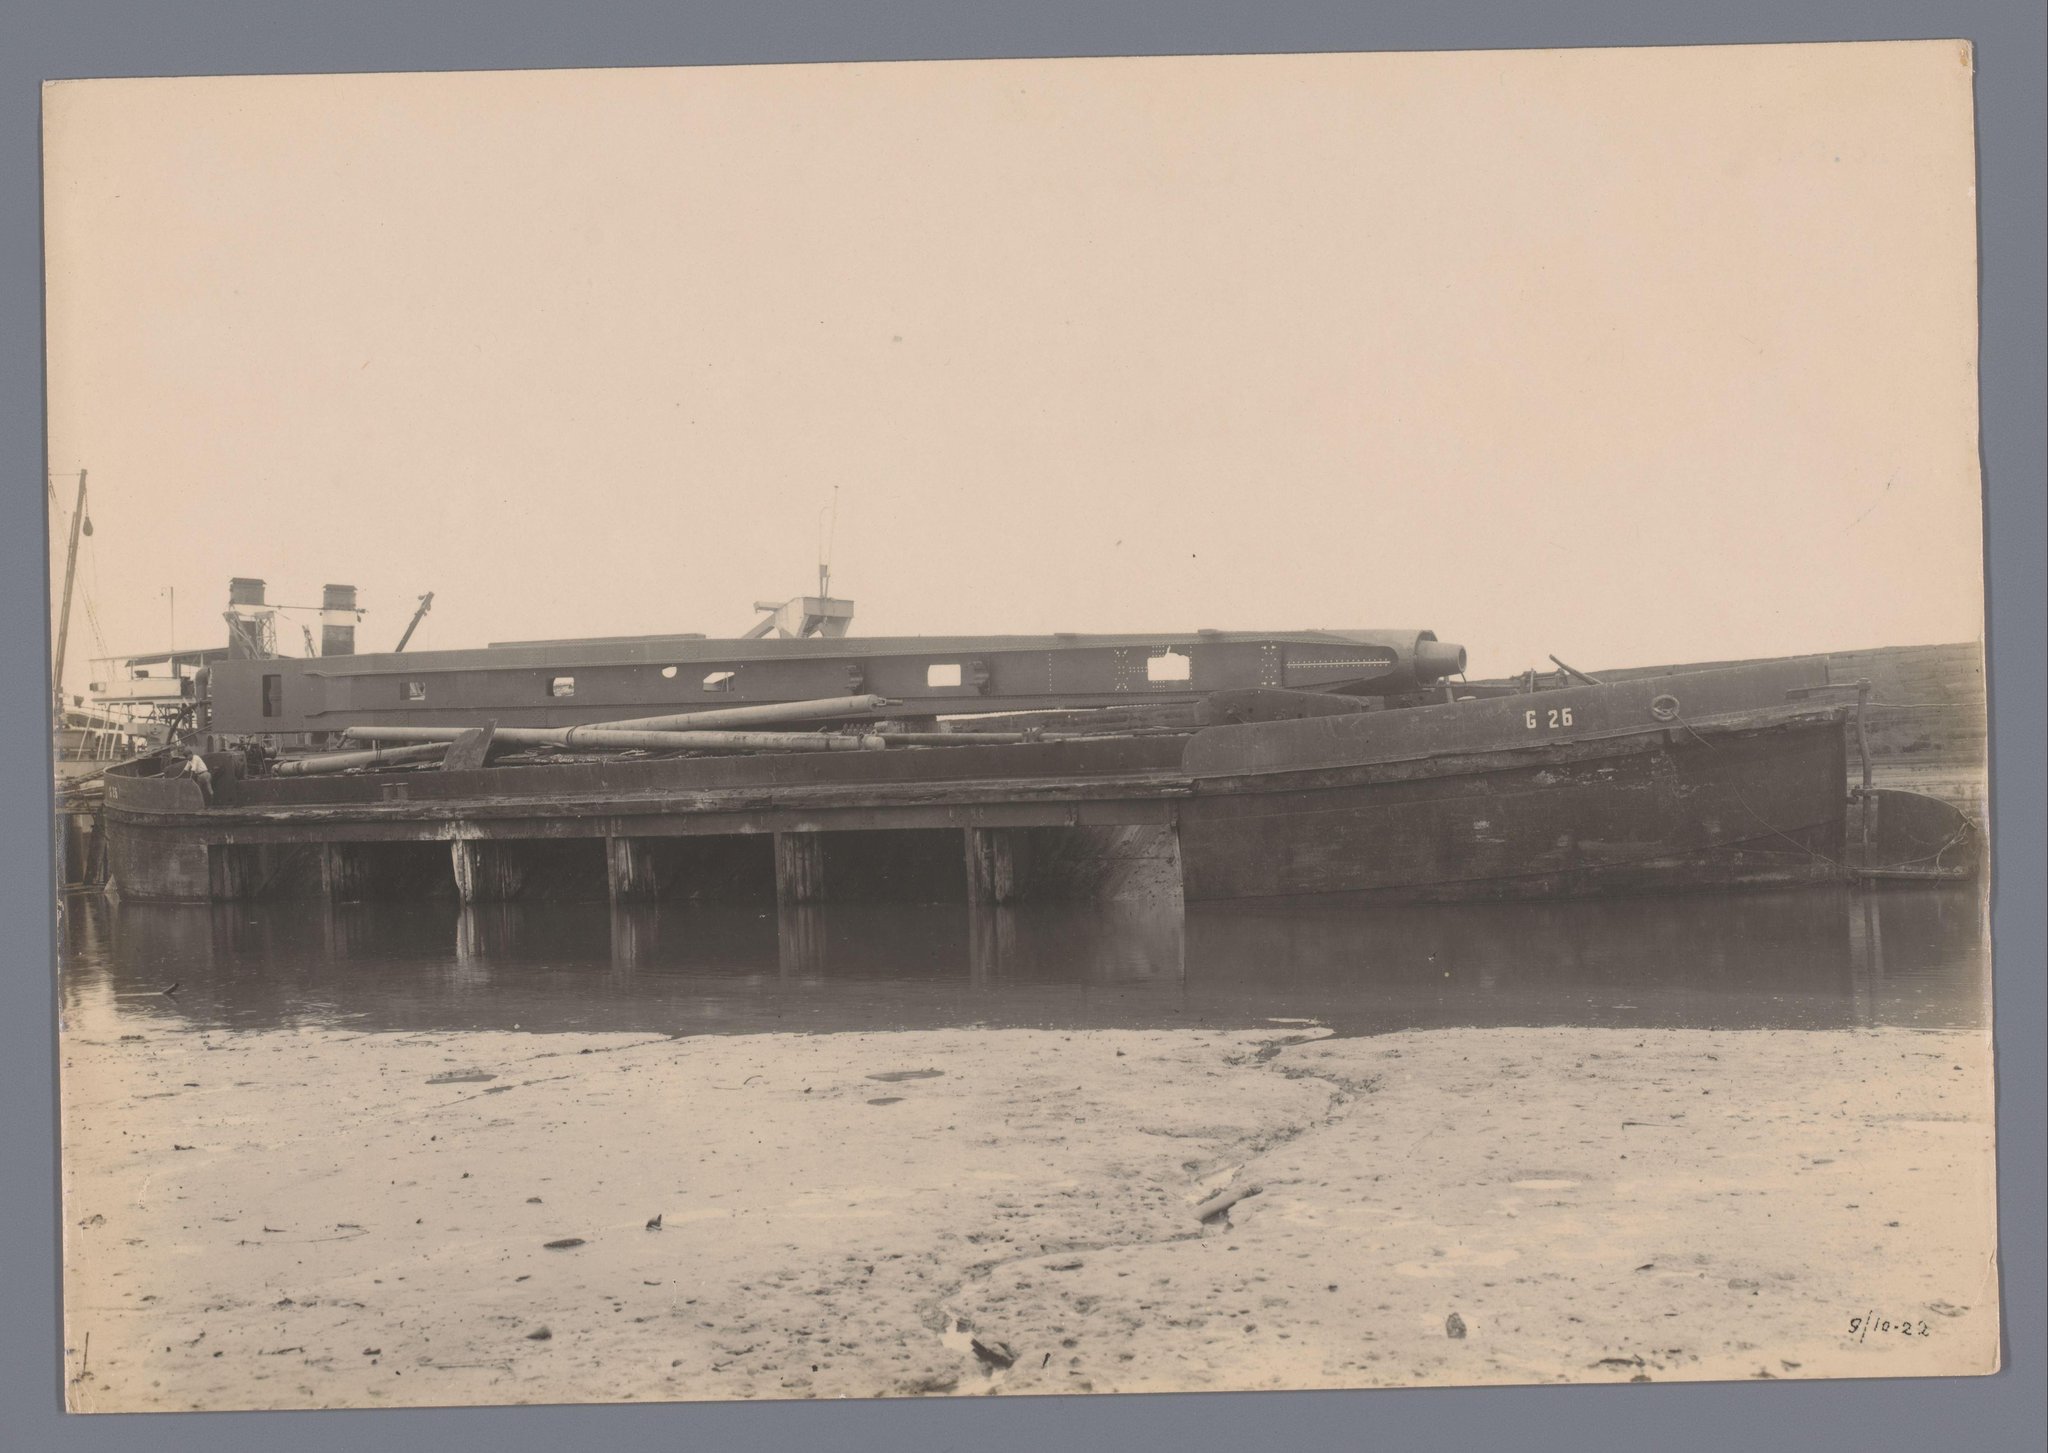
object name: photograph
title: G. 26 Zijlosser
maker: Anonymous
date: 1922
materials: photographic support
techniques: gelatin silver print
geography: belawan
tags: motorized barge, building-site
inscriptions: date: ‘9/10-22’, annotation: ‘No. 245 G. 26 Zijlosser’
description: Zijlosser, transportschip. Genummerd: 245. Onderdeel van de groep van losse foto's over de aanleg van de haven Belawan aan de kust voor Medan, Sumatra 1921-1922.